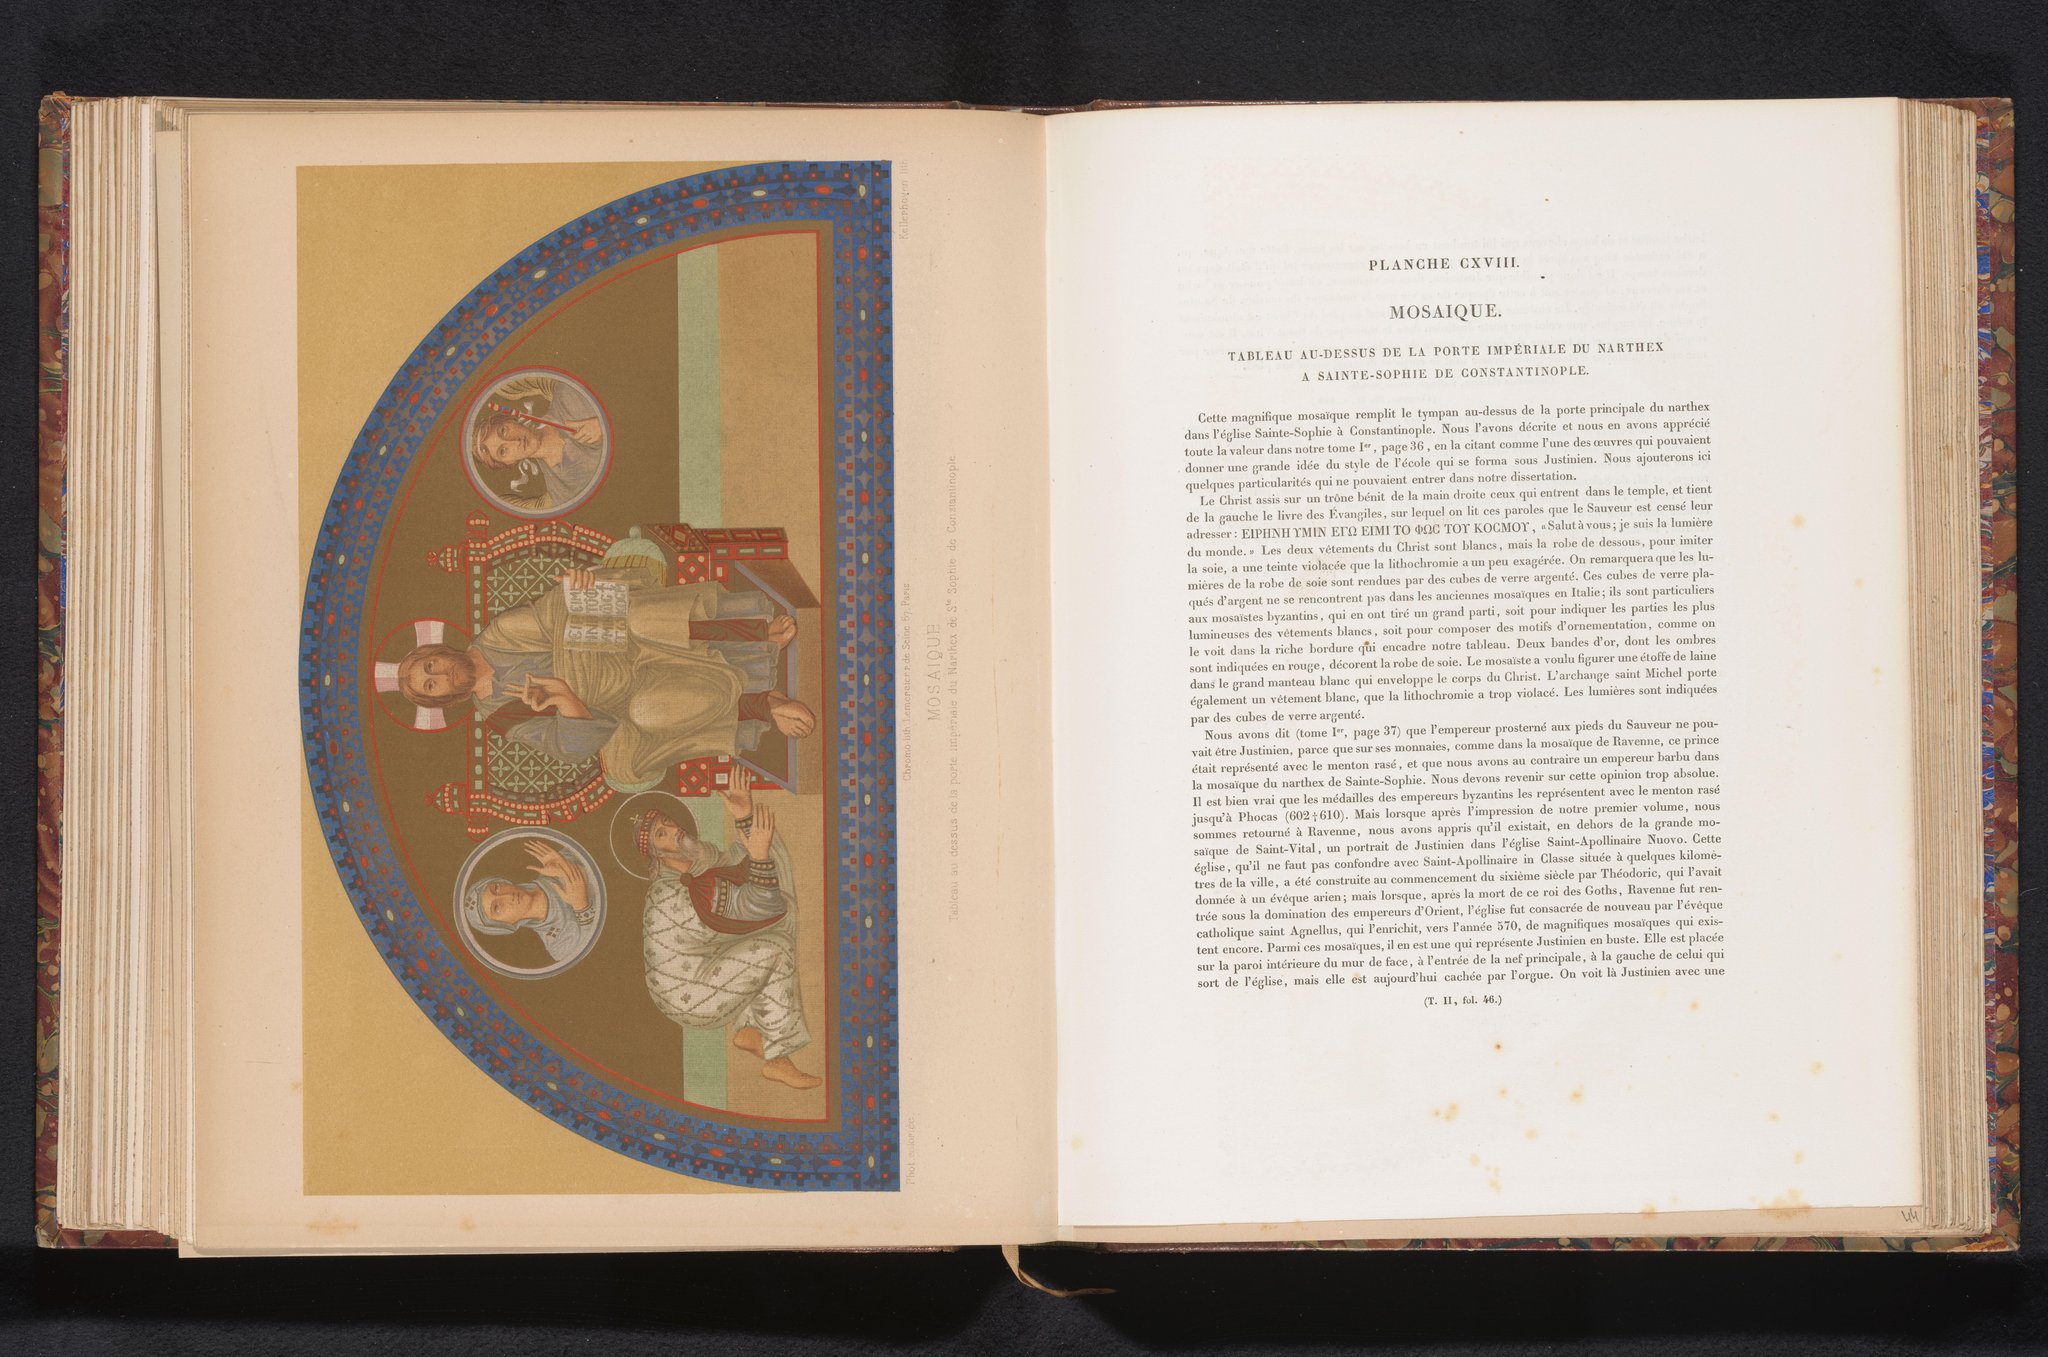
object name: page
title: Reproductie van een mozaïek in de Hagia Sophia met Christus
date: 1859-1864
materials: paper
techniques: photolithography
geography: paris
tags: christ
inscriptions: name: ‘Phot. coloriee./ Kellerhoven lith.’